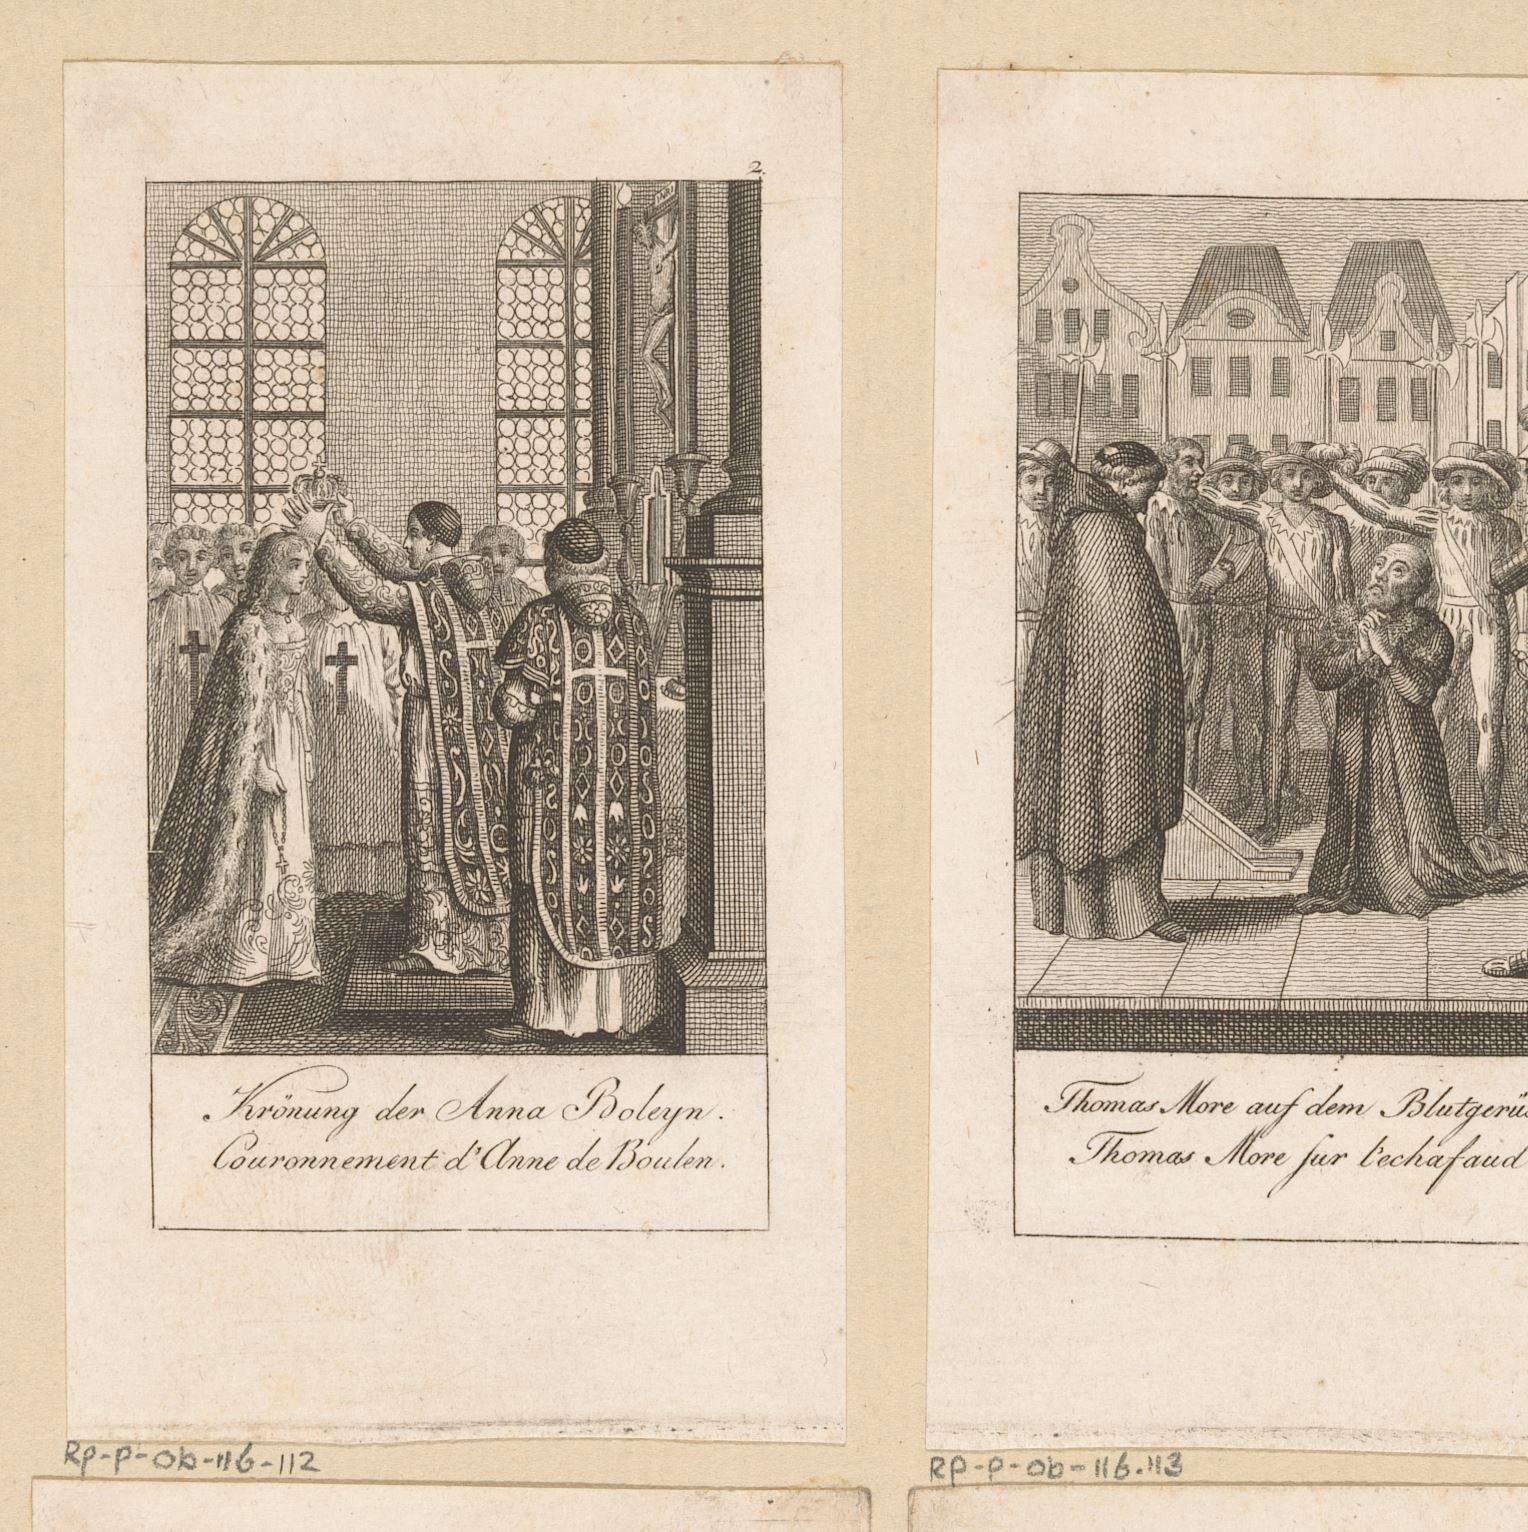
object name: print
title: Voorstelling uit de geschiedenis van Hendrik VIII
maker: christian gottlieb geyser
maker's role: print maker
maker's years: 1742-1803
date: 1796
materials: paper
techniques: etching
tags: london, coronation of a ruler - bb - female ruler, history, historical persons - bb - woman, ruler, sovereign - bb - female ruler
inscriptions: collector's mark: Lugt 2228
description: Prent gebruikt voor: Geschichte der Statthalterschaft der Niederlande. Gotha: s.n., 1796.